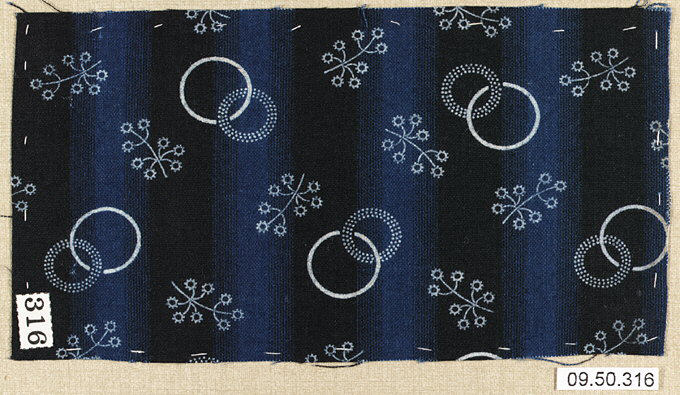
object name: piece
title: Piece (one of 116)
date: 1801-1900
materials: cotton